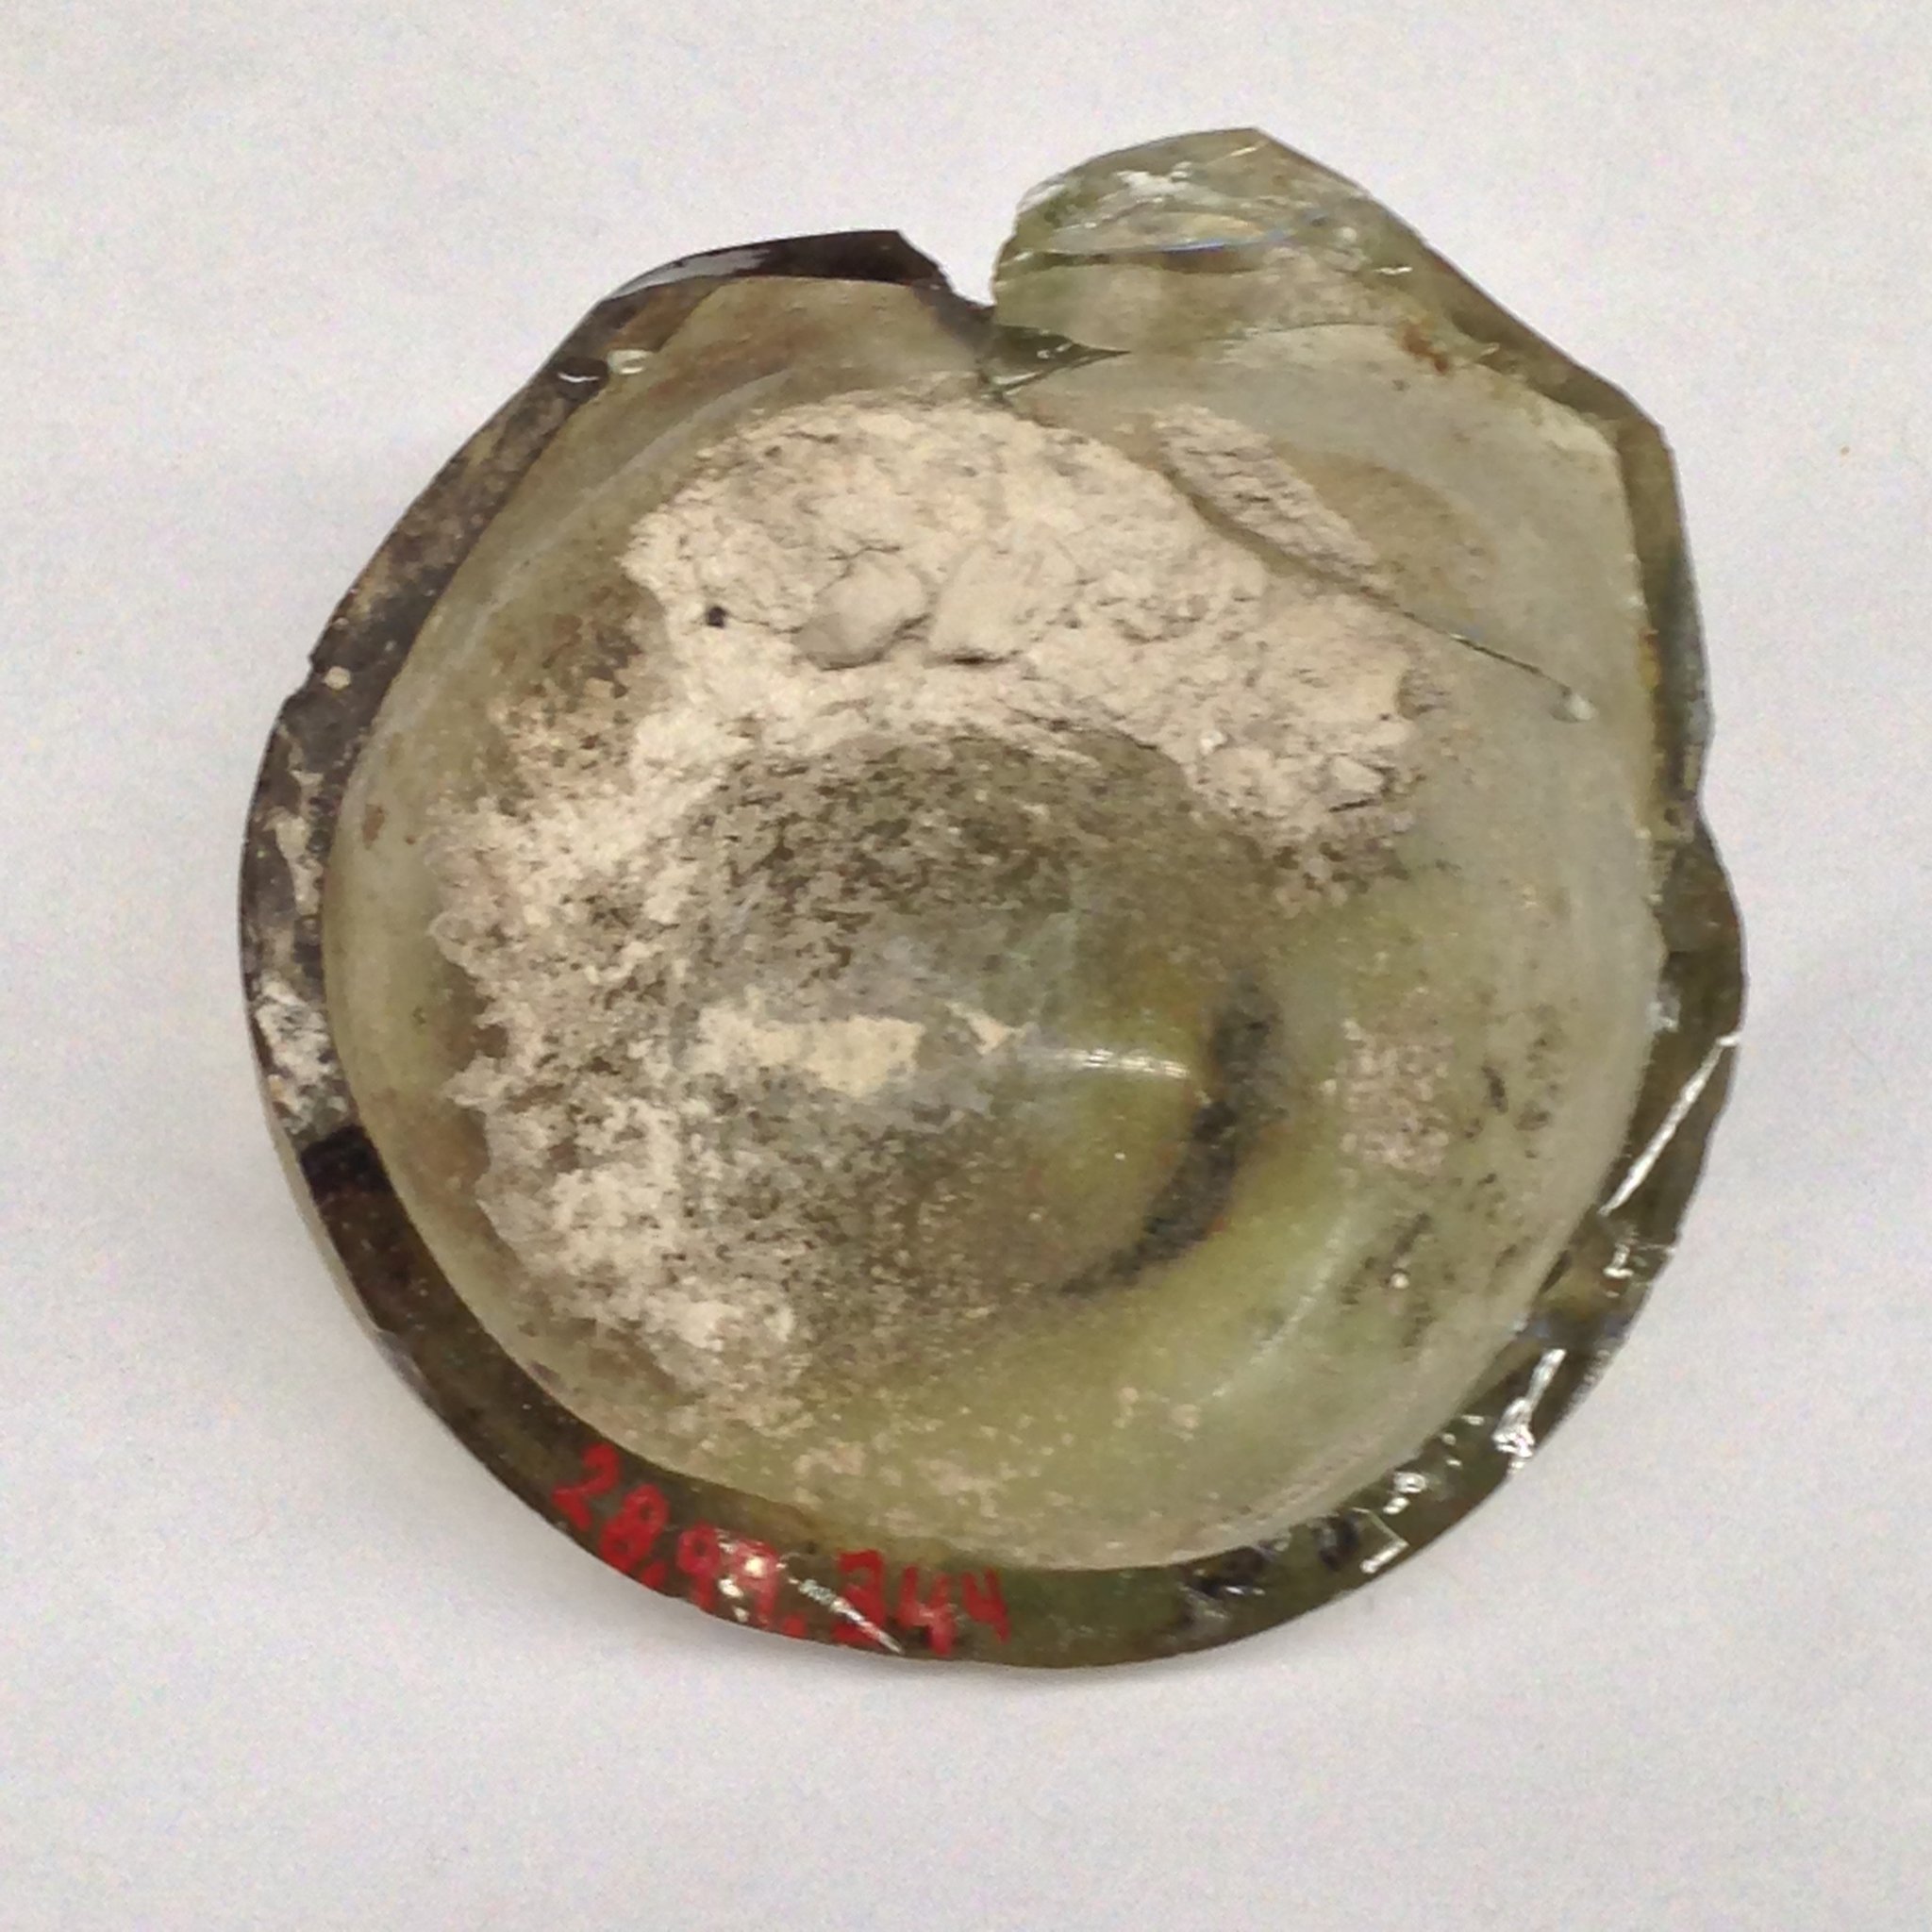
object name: fragment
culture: european or middle eastern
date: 1150-1250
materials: ceramic, glass